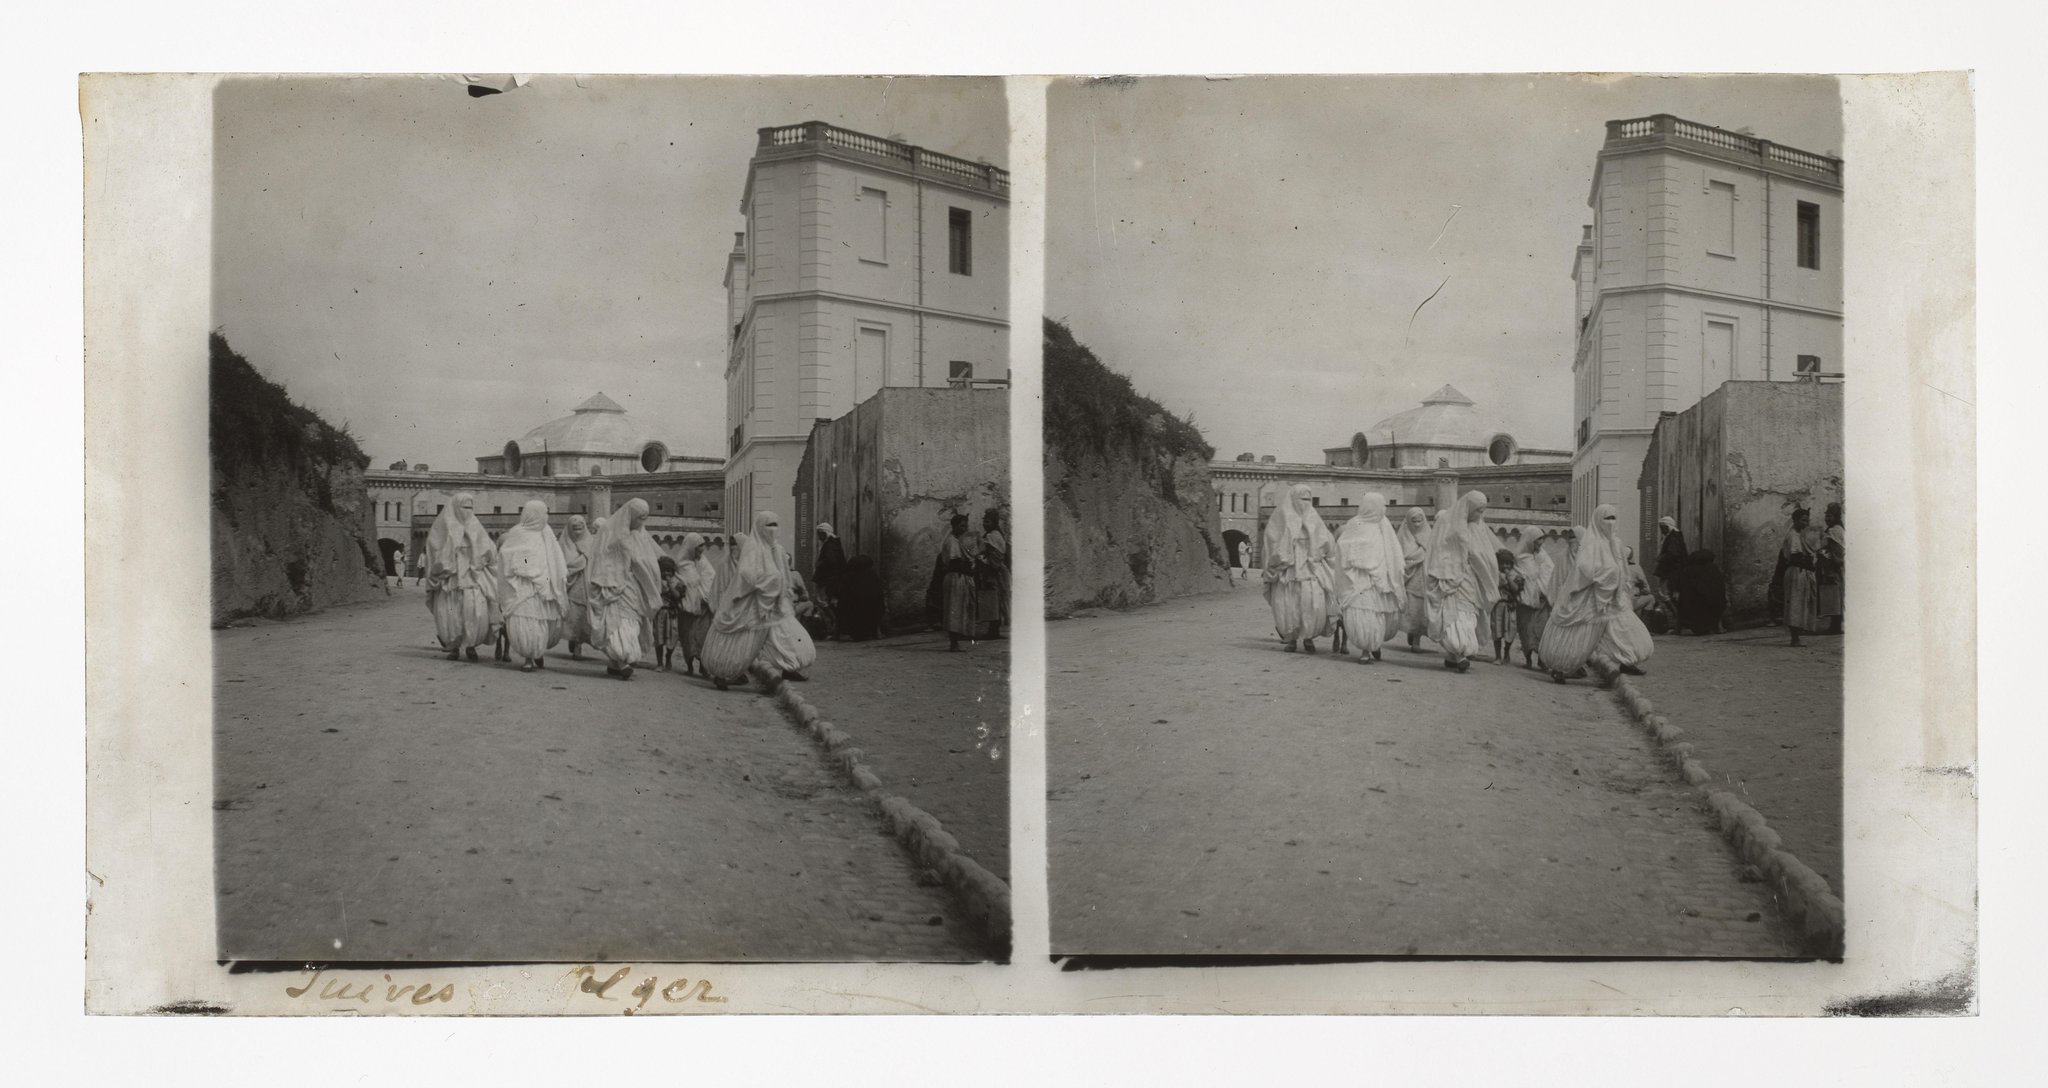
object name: stereoscopic photograph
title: Joodse mensen op straat in Algiers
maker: Anonymous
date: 1810-1890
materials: glass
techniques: slide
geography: algiers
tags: street (+ city(-scape) with figures, staffage)